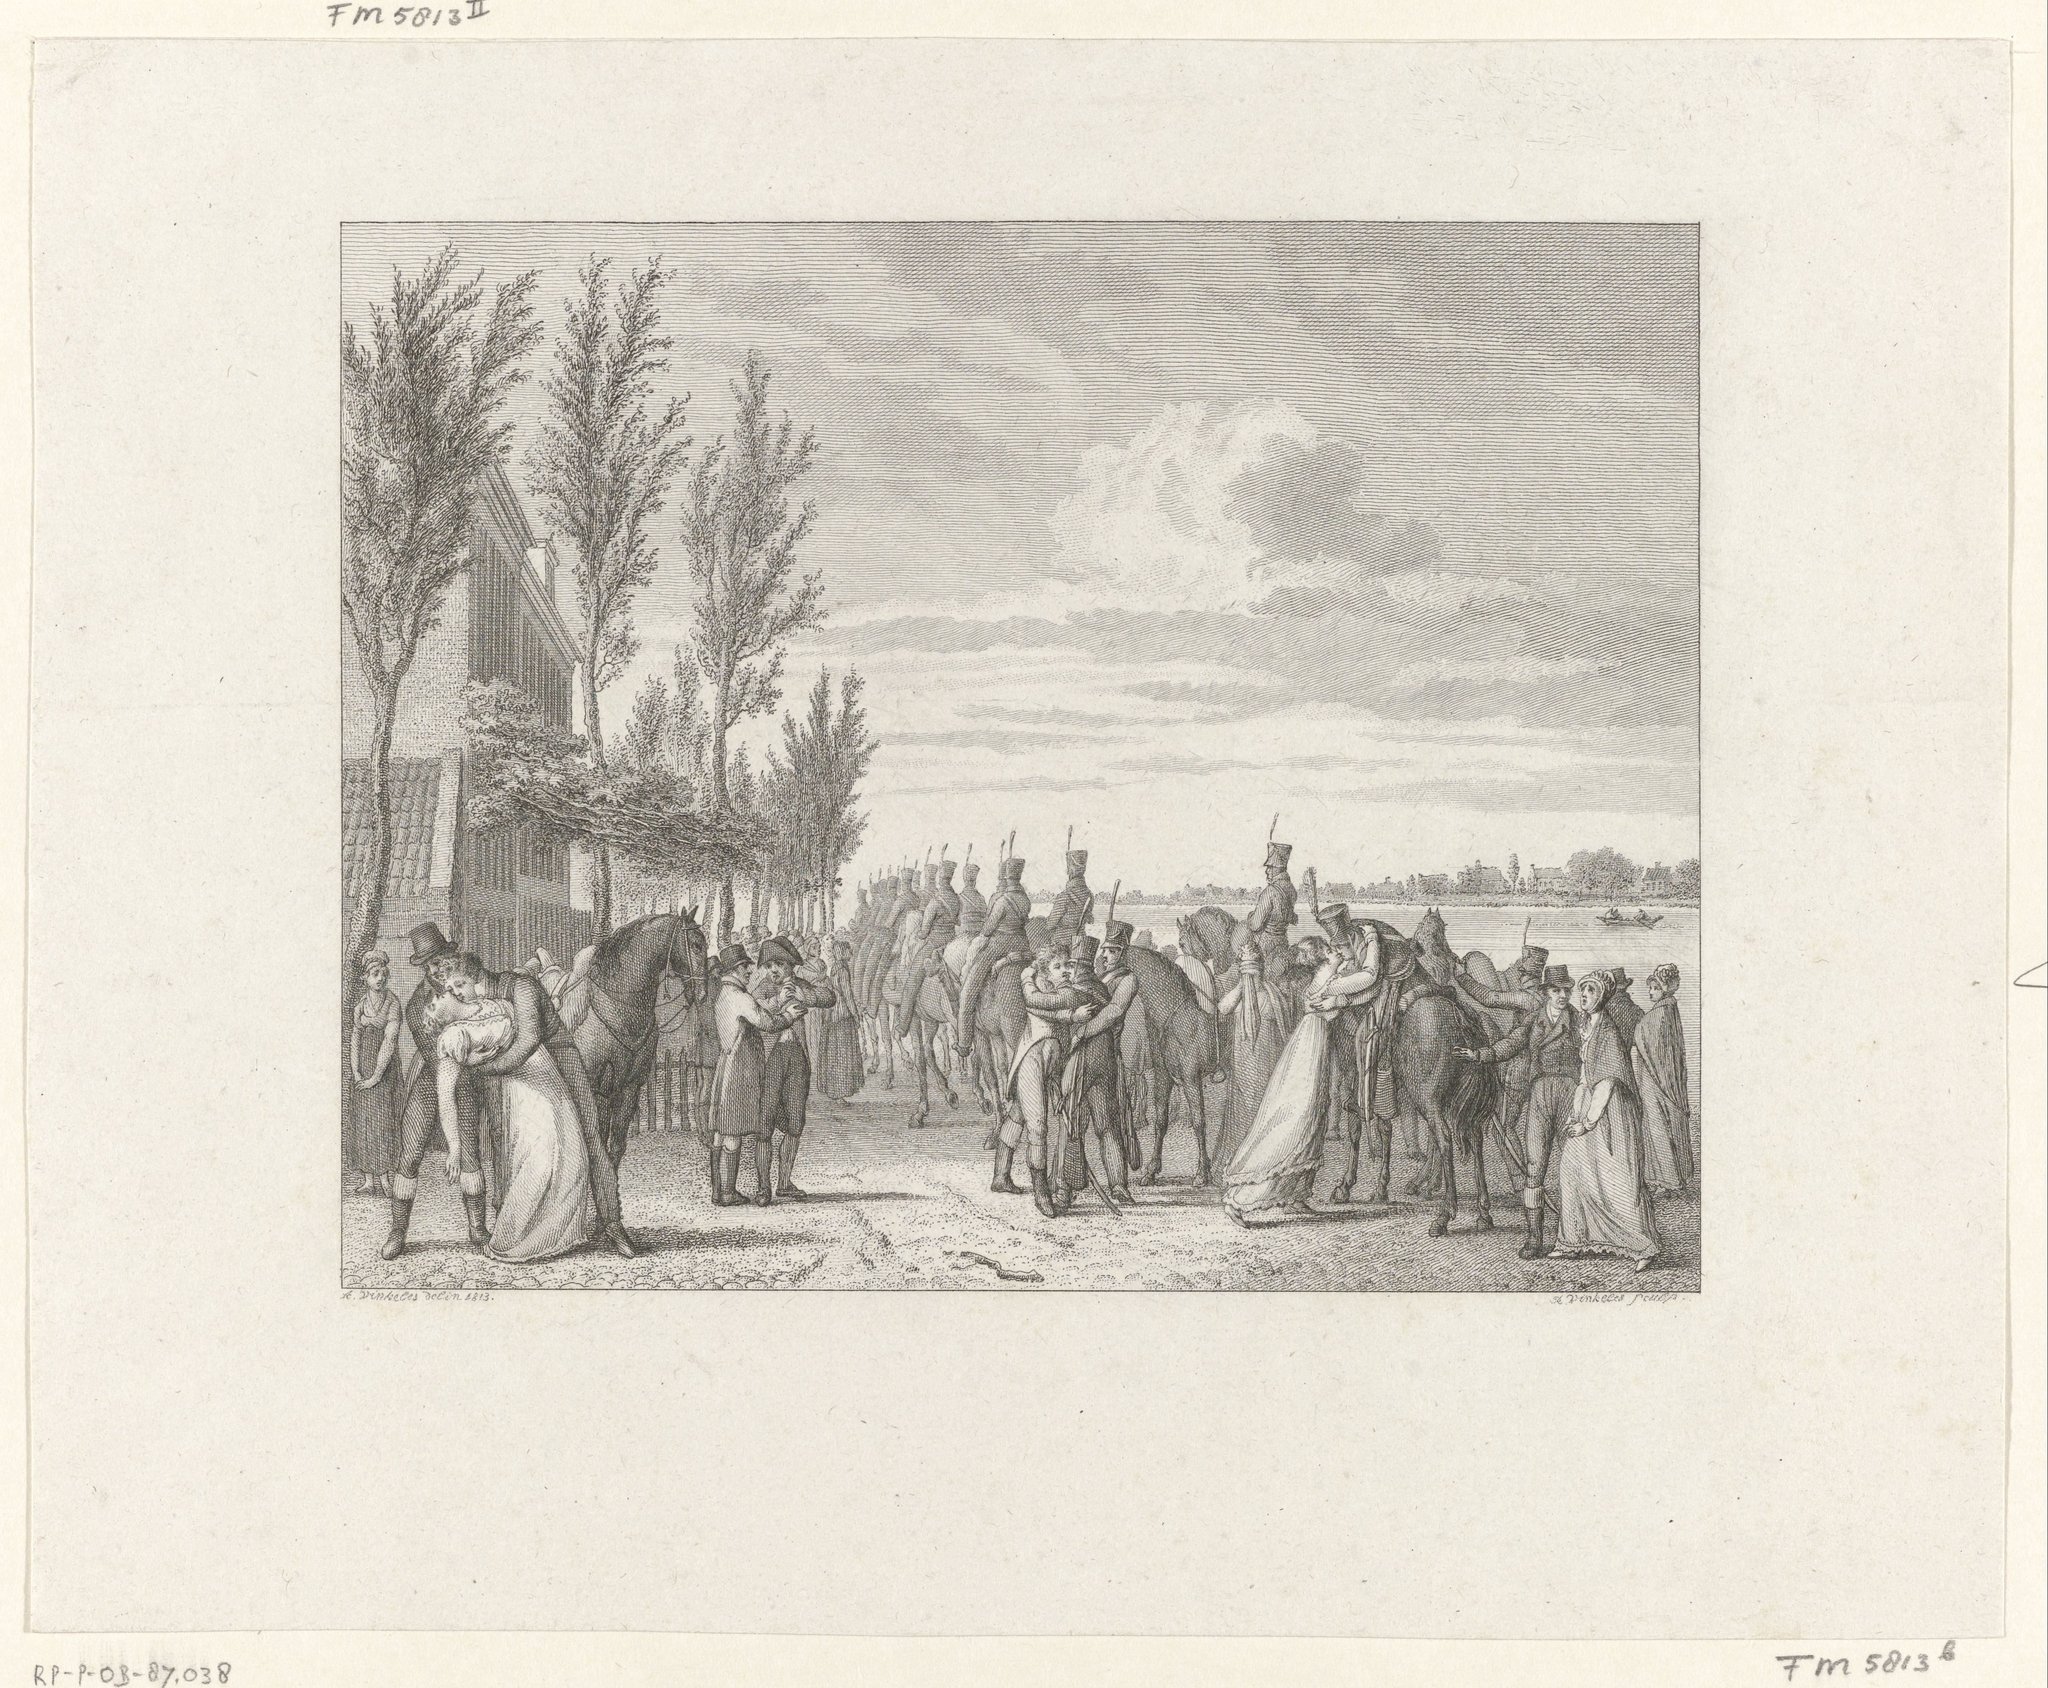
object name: print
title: Vertrek van de Gardes d'Honneur van Amsterdam, 1813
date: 1813-1815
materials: paper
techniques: engraving, etching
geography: netherlands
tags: guard of honour, taking leave, amsterdam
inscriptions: collector's mark: Lugt 2228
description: Gebruikt als illustratie in: De Gardes d'Honneur in vier zangen, Dirk Hendrik ten Kate van Loo, Den Haag: Johannes Allart, 1815.